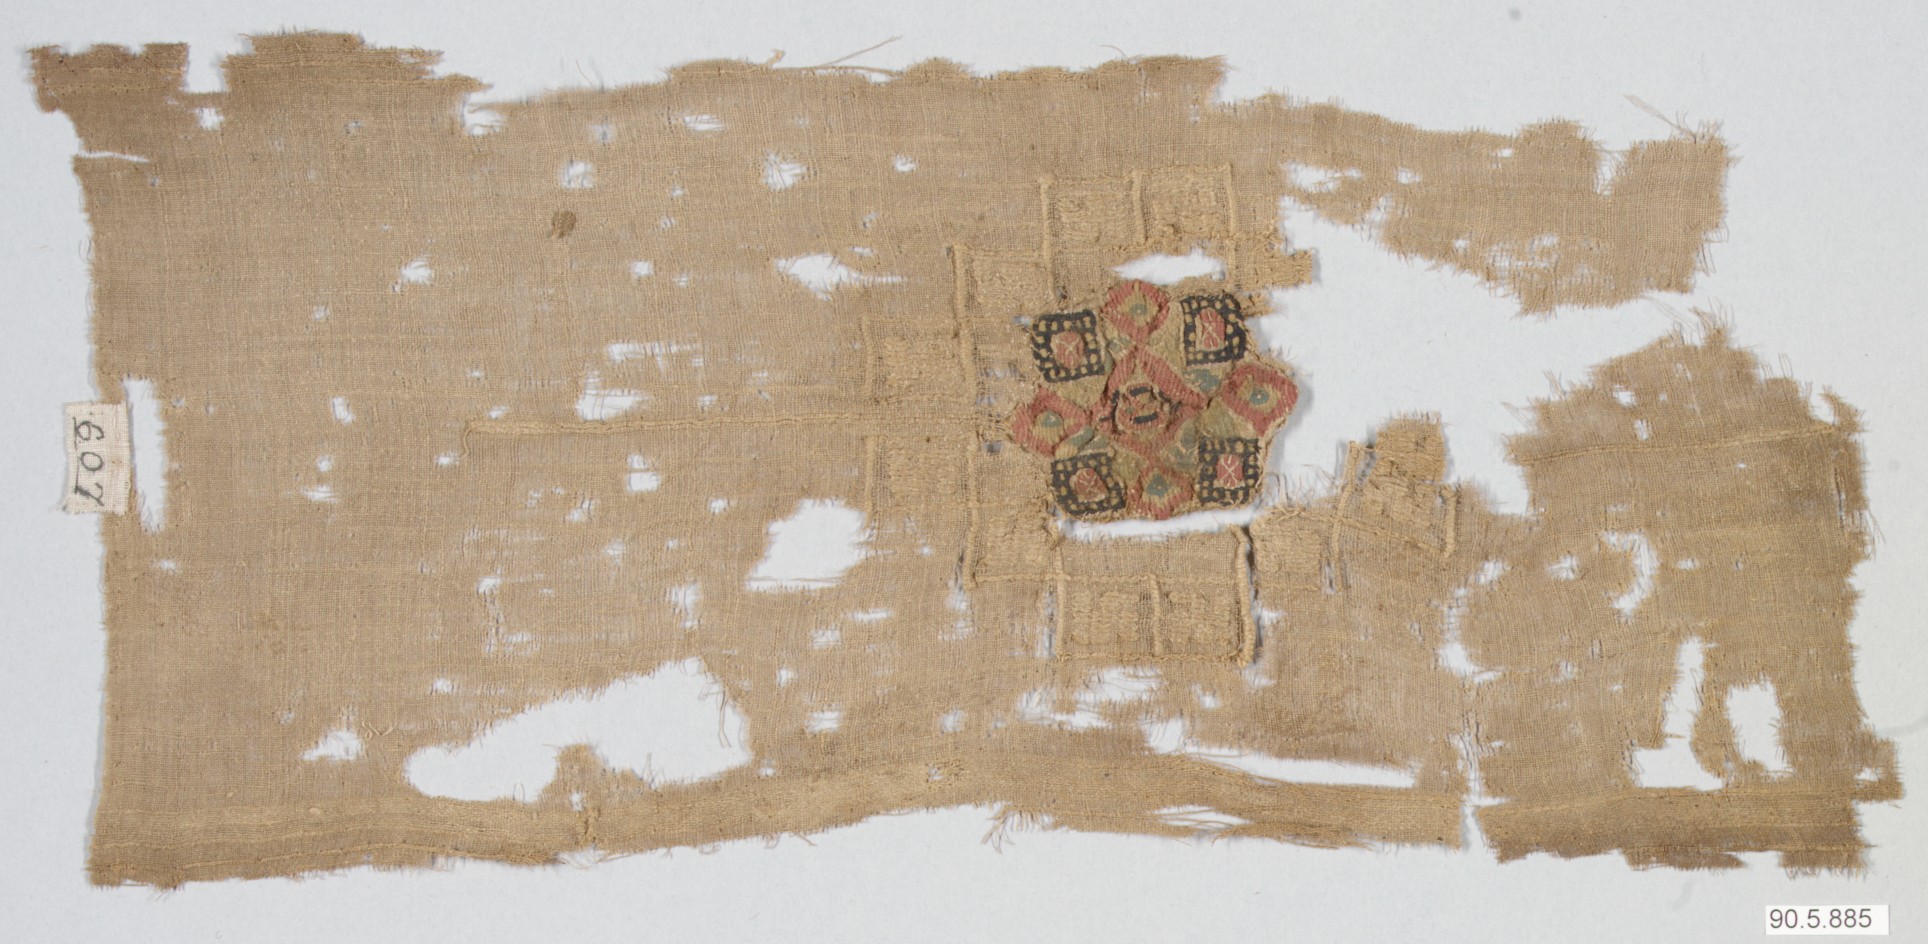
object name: textile fragment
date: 301-500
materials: linen, wool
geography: egypt